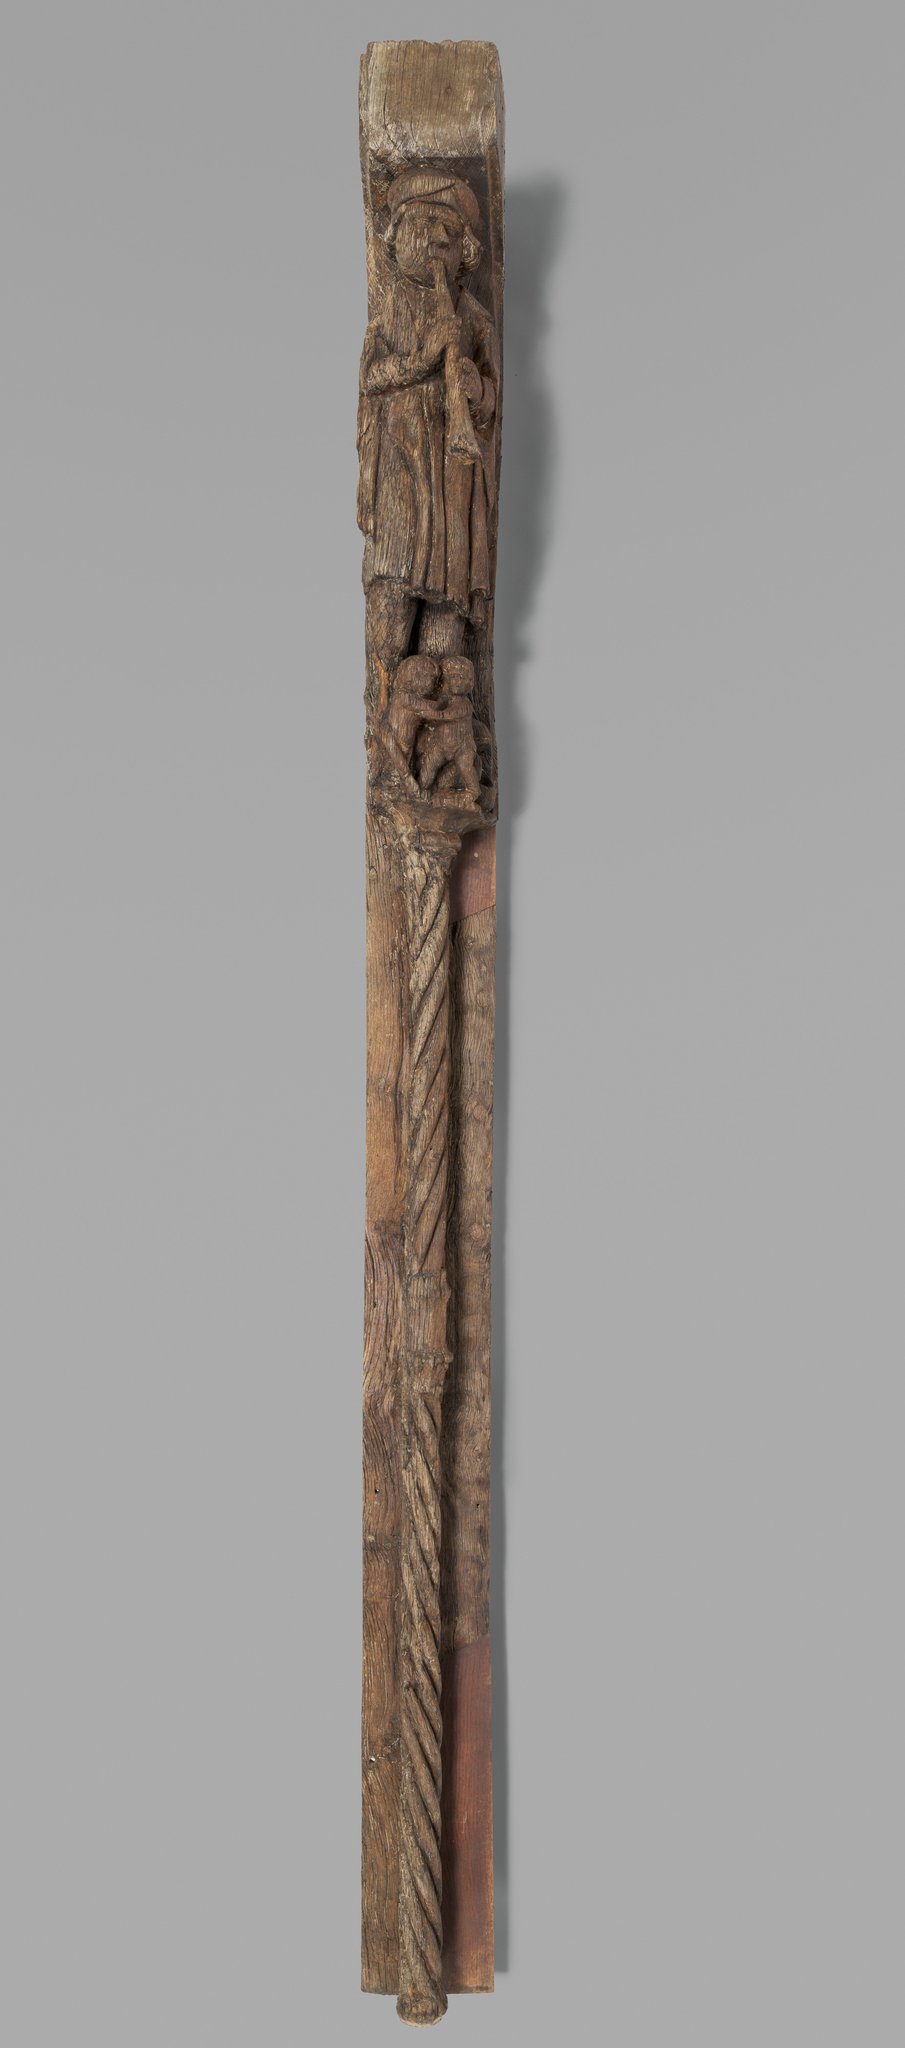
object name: architectural support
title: Architectural Support with a Flute-Player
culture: french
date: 1524-1525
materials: wood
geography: england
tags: flutes,musicians